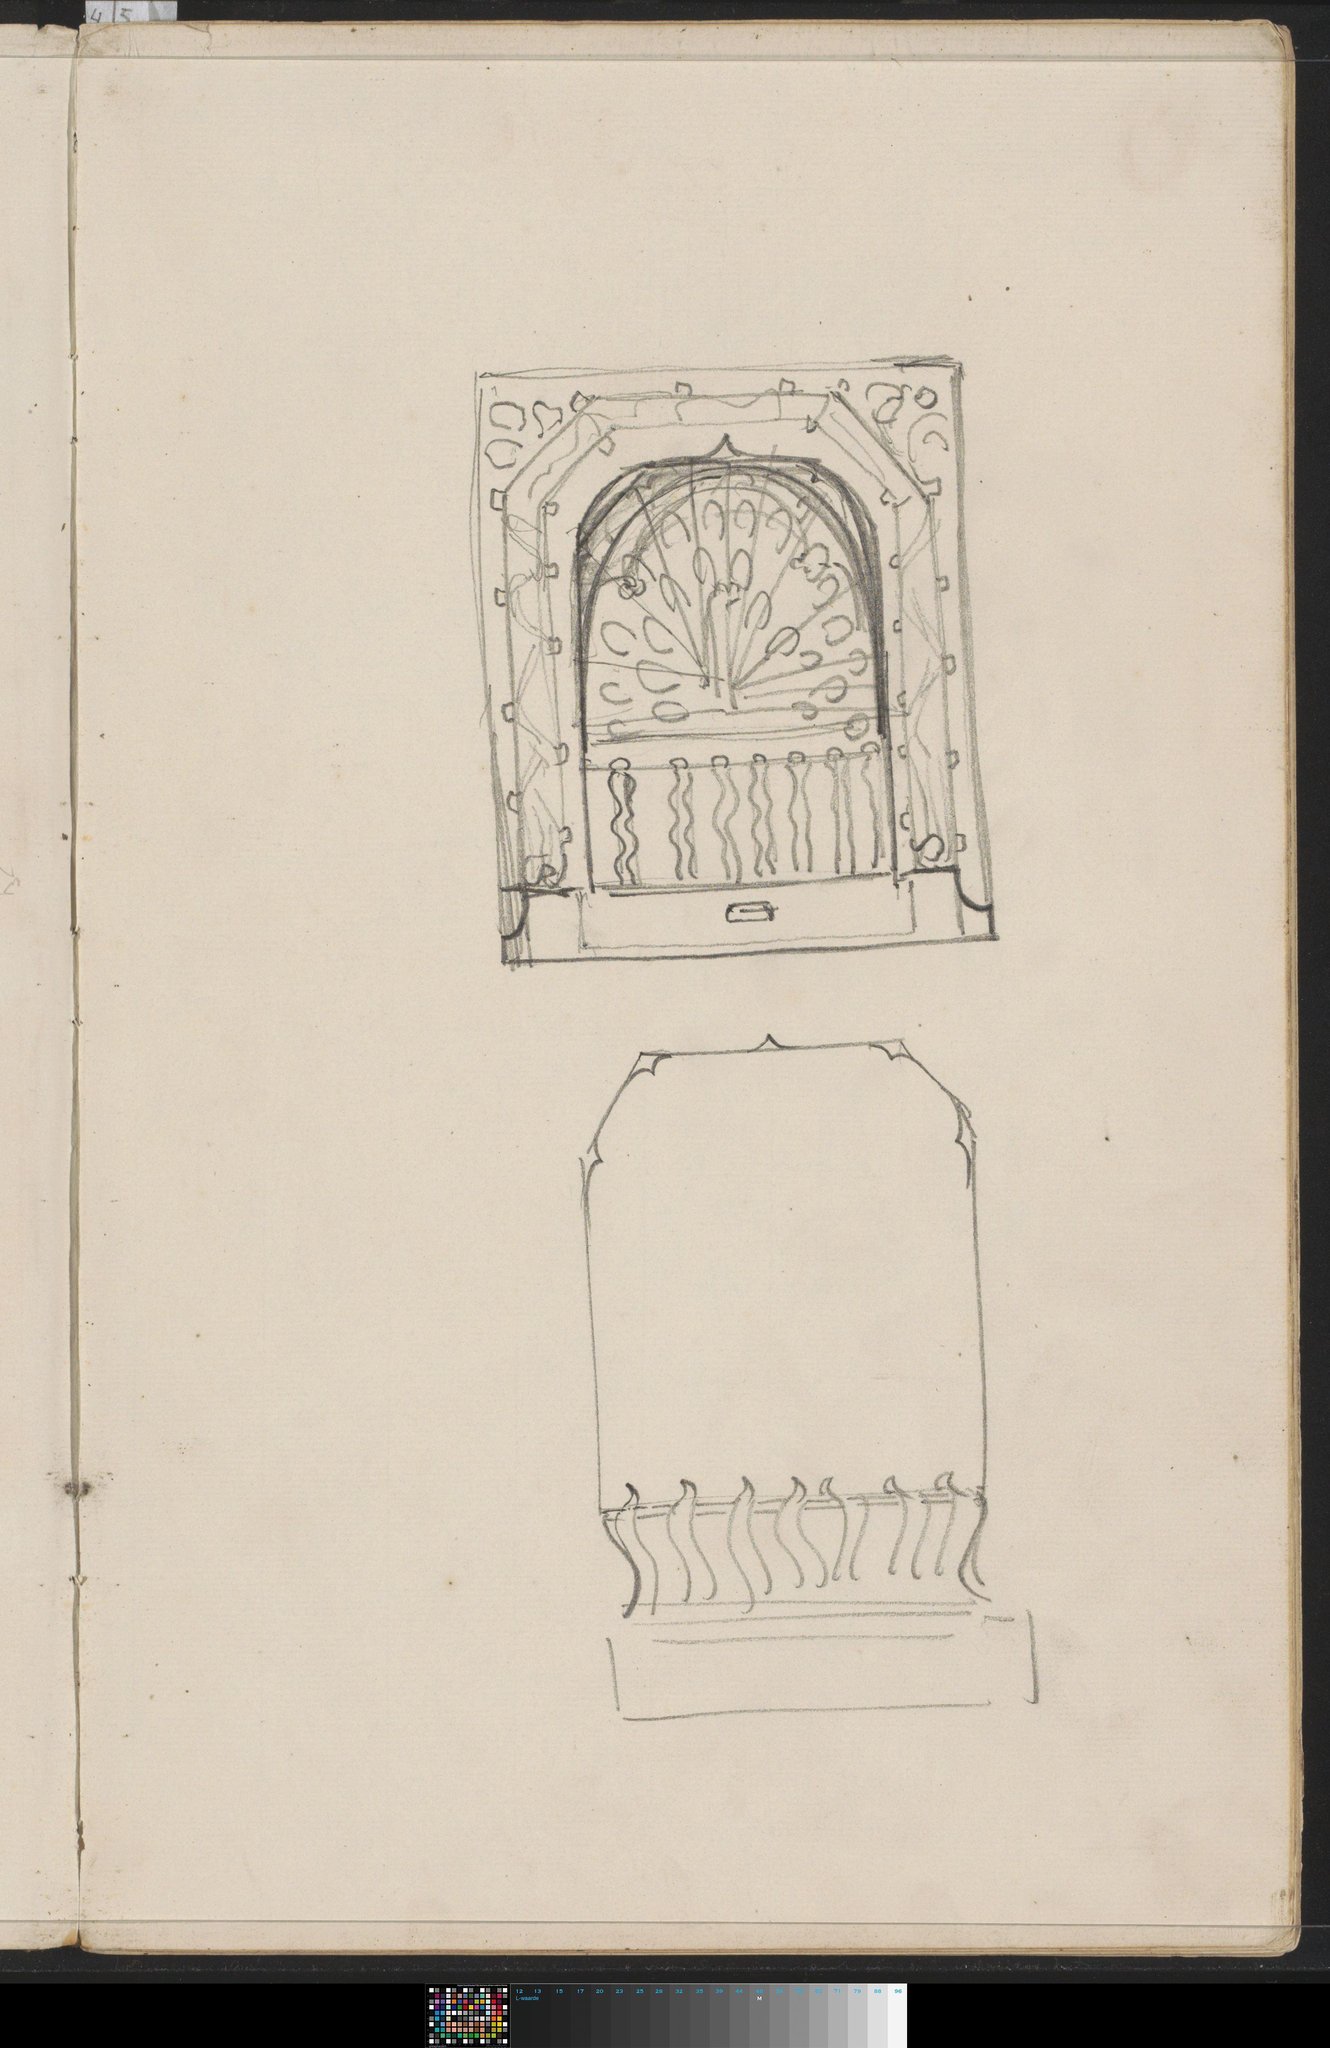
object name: sketchbook leaf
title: Ontwerpen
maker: carel adolph lion cachet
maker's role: draughtsman, print maker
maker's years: 1864-1945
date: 1897-1898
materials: paper, pencil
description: Mogelijk decoratie voor een meubelstuk. Blad 2 recto uit een schetsboek met 29 bladen.